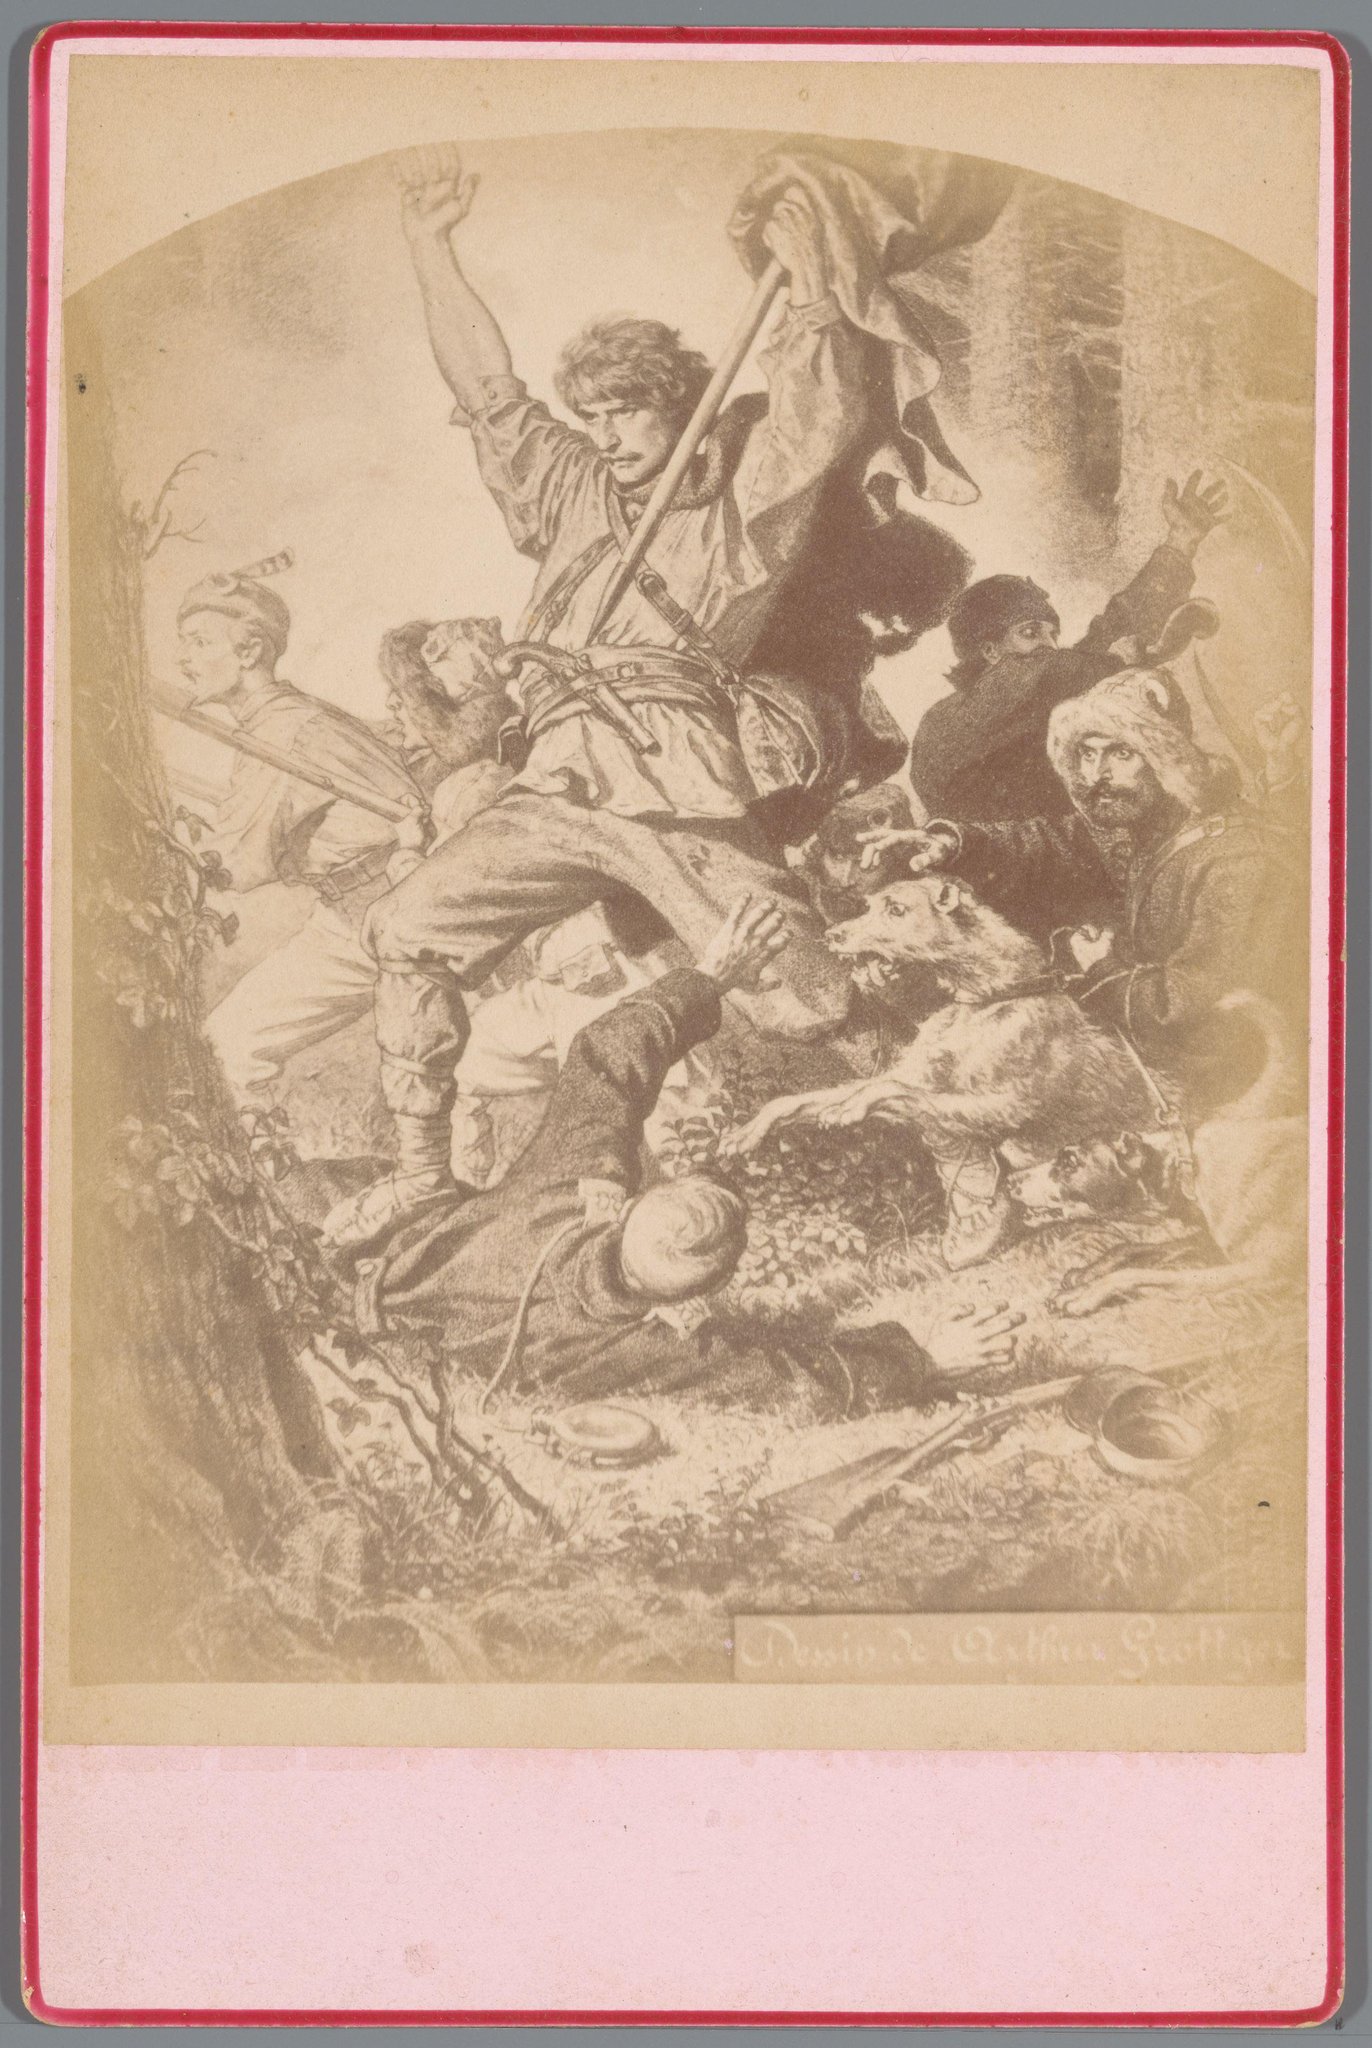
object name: reproduction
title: Fotoreproductie van de tekening door Arthur Grottger uit de serie Litouwen, voorstellende een man met een vlag tijdens een gevecht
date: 1870-1890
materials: cardboard, photographic support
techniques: albumen print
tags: drawing, sketch, battle, flag, colours (as symbol of the state, etc.)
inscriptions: name: ‘[...]ert [...]ograf’, name: ‘Vosmaer’